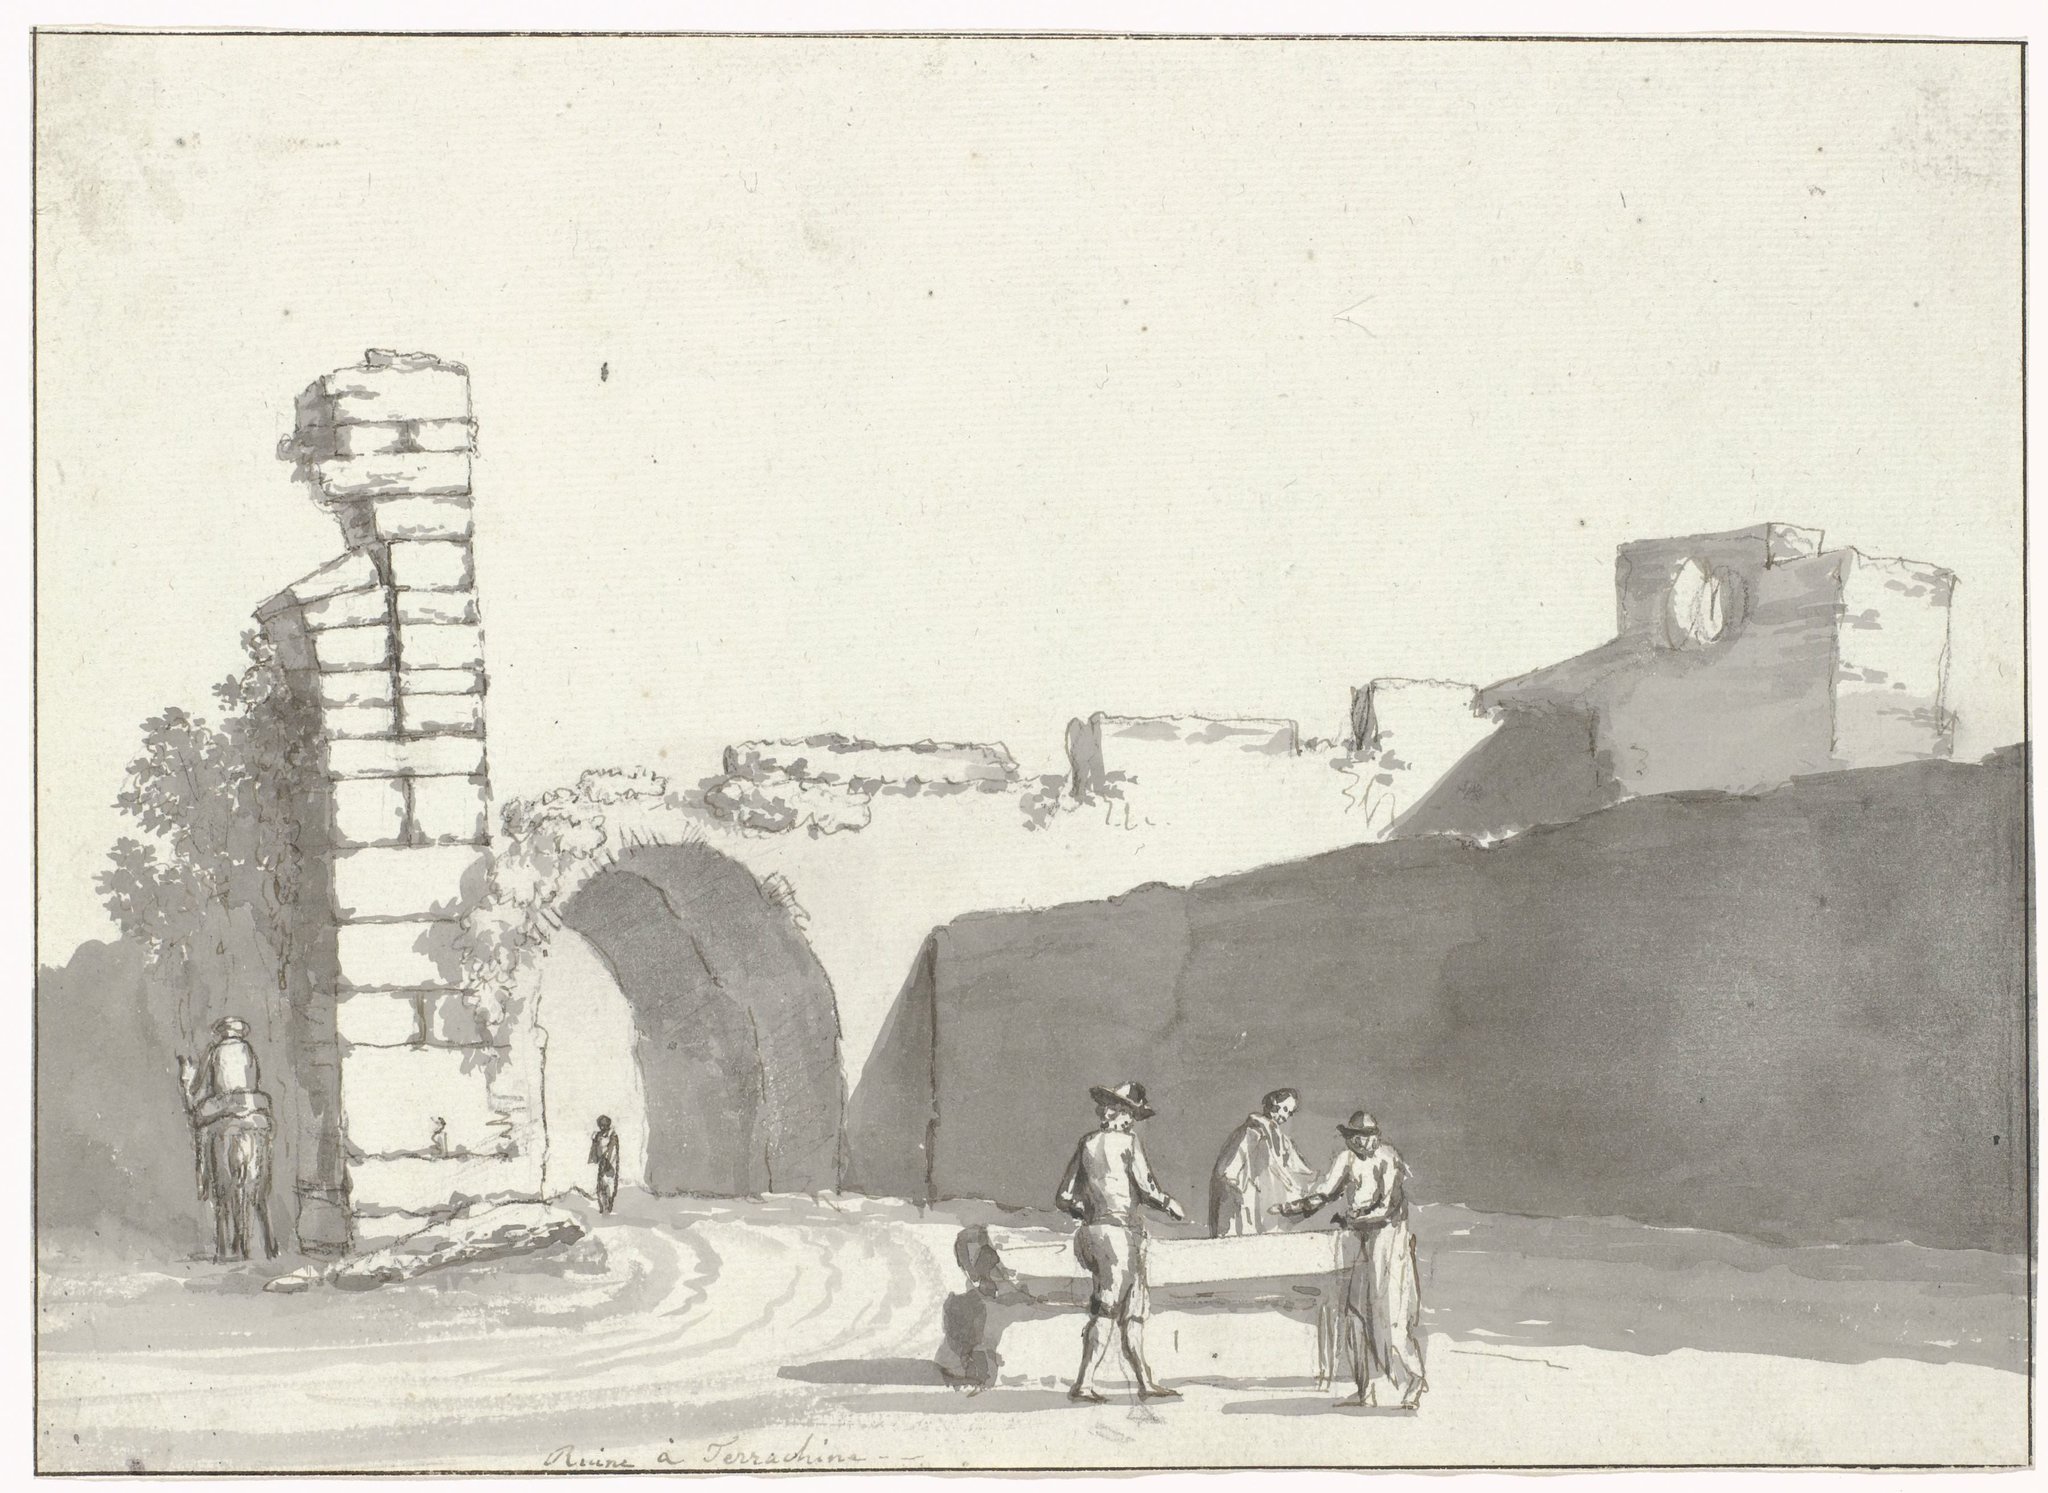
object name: drawing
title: Voyage en Italie, en Sicile et à Malte - 1778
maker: louis ducros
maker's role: draughtsman, print maker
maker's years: 1748-1810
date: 1778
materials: chalk, paper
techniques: brush, pen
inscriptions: number: ‘No 2 Ruïnes avant d'arriver à Terracina’